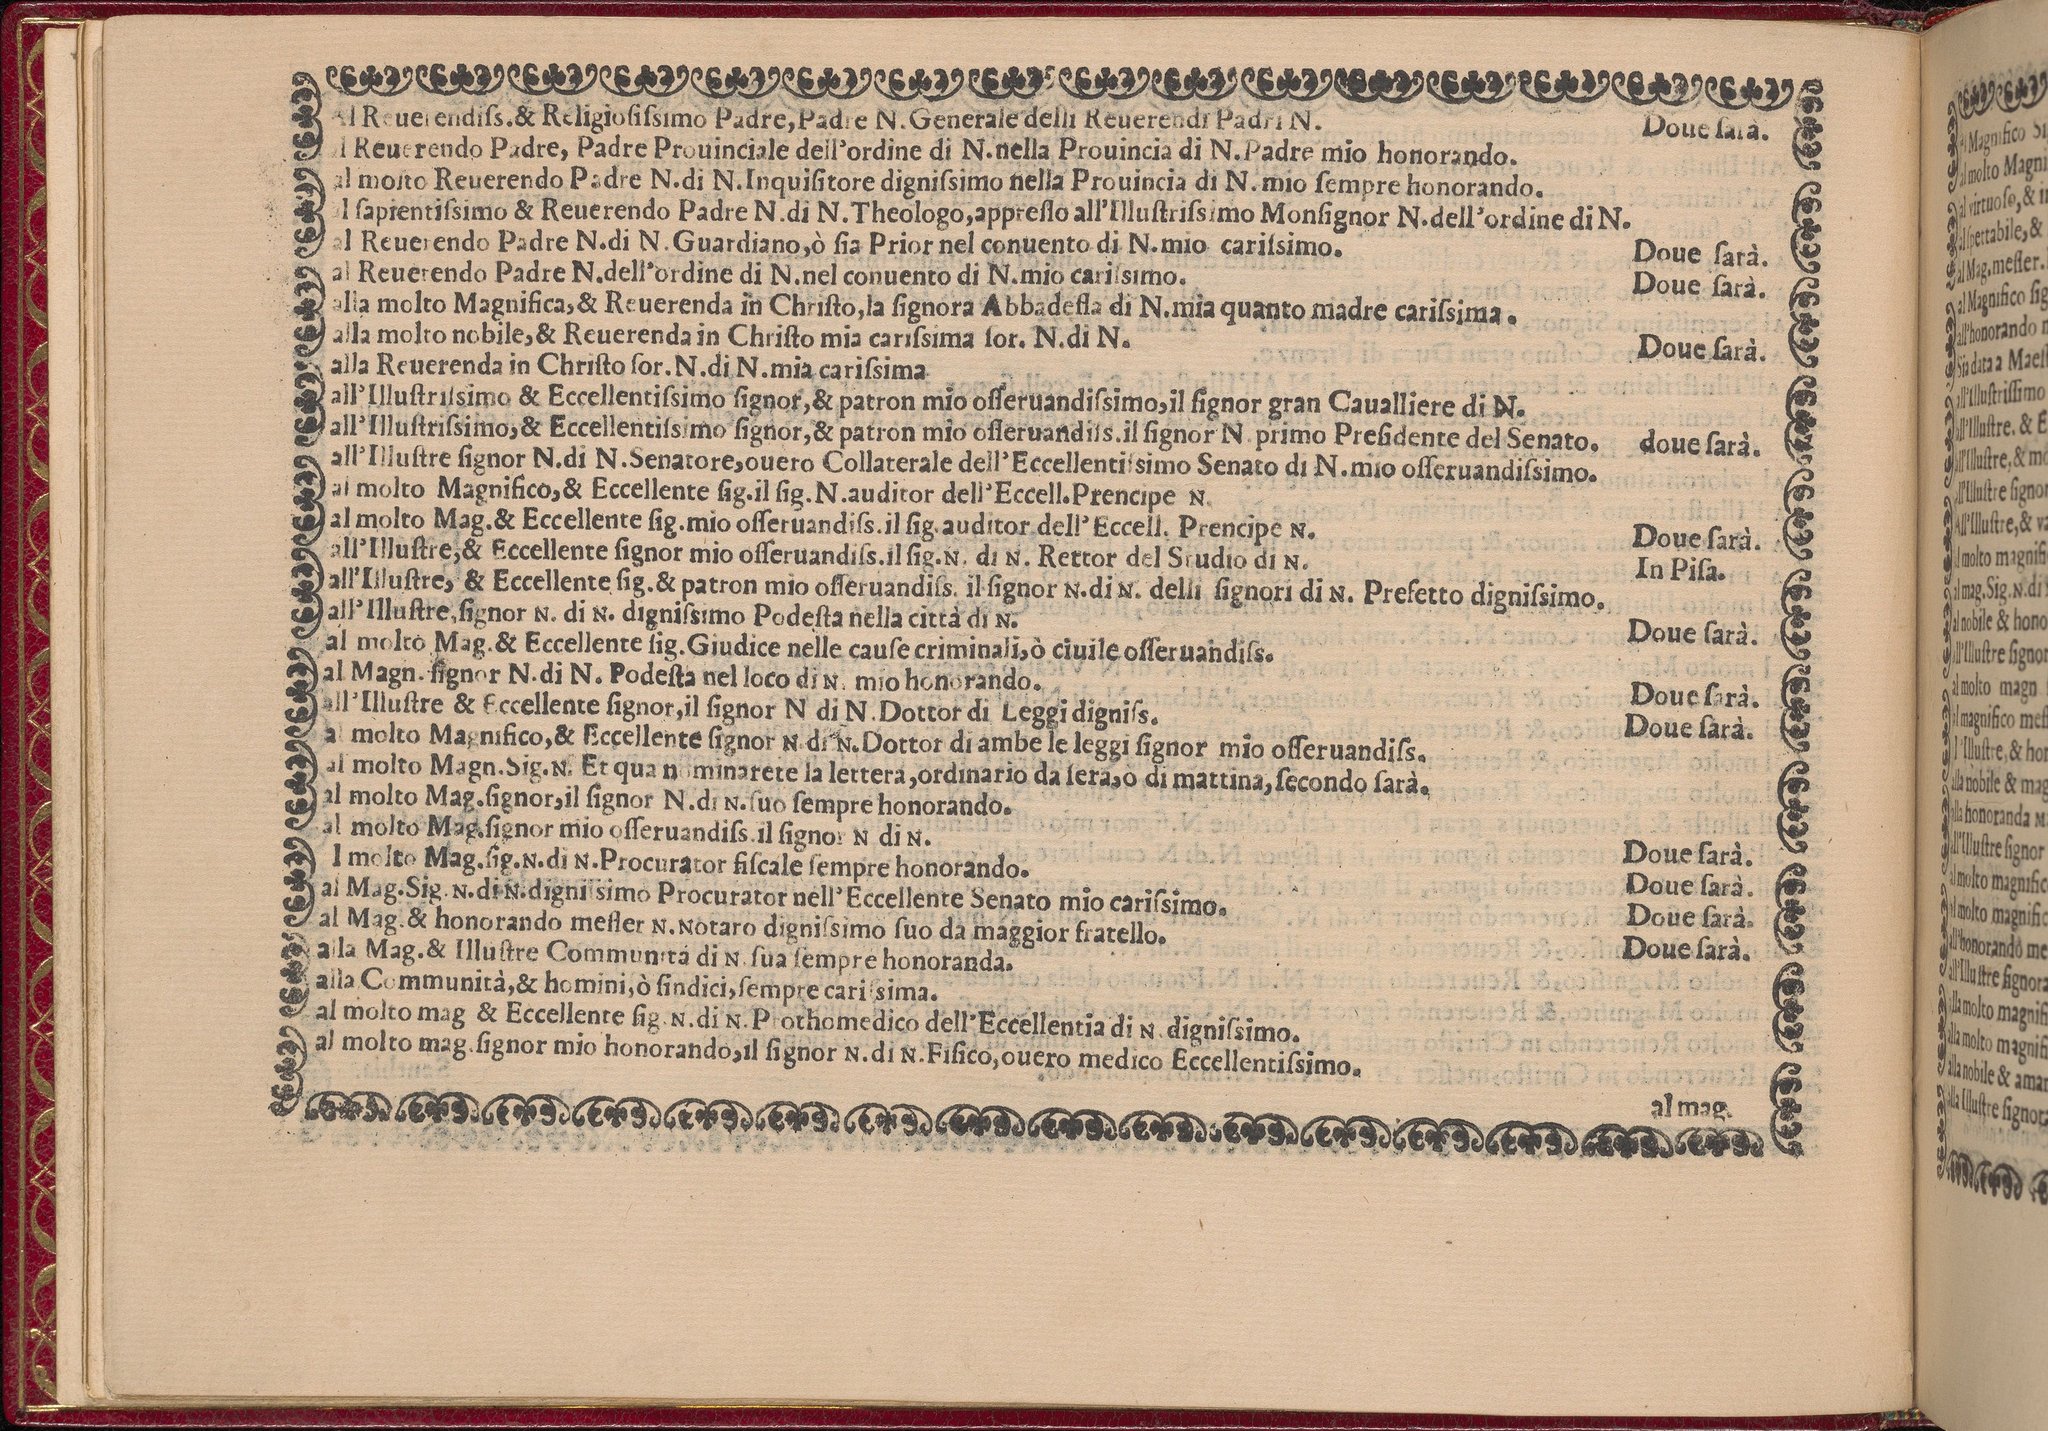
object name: book print ornament architecture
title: Ghirlanda: Di sei vaghi fiori scielti da piu famosi Giardini d'Italia, page 5 (verso)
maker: pietro paulo tozzi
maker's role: designer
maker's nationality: italian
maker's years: 1593-1628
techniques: drawing, etching